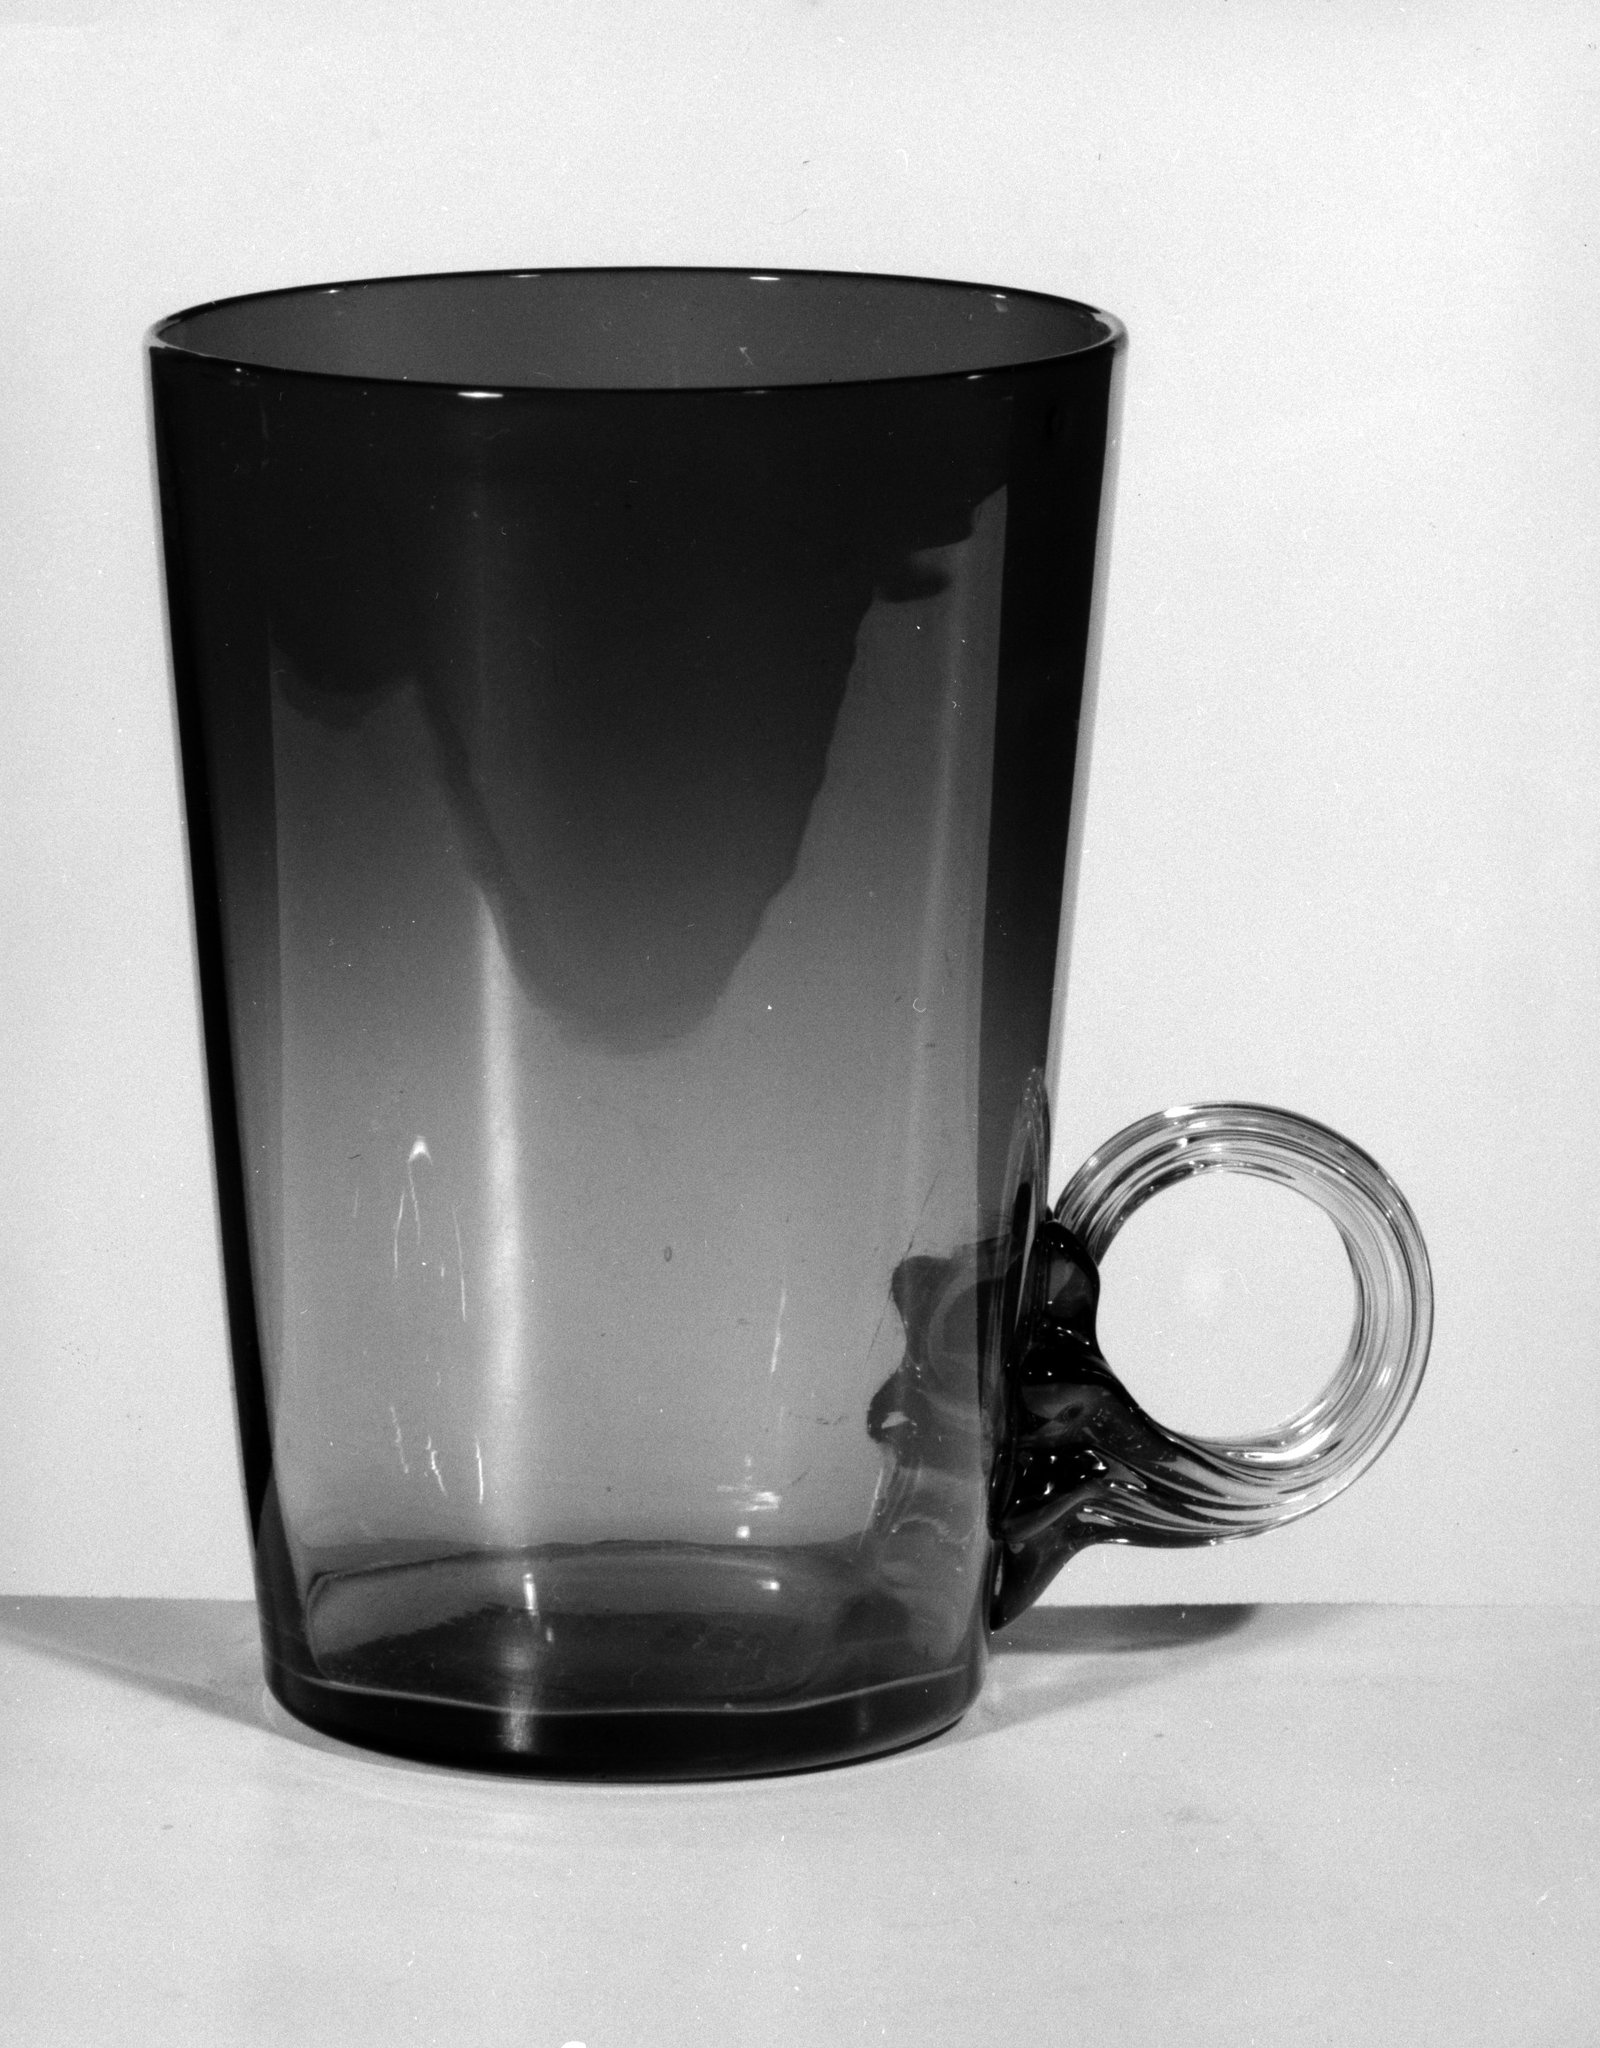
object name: punch glass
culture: american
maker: new england glass company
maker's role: maker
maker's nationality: american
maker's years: 1818-1888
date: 1883-1888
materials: glass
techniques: glassblowing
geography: united states